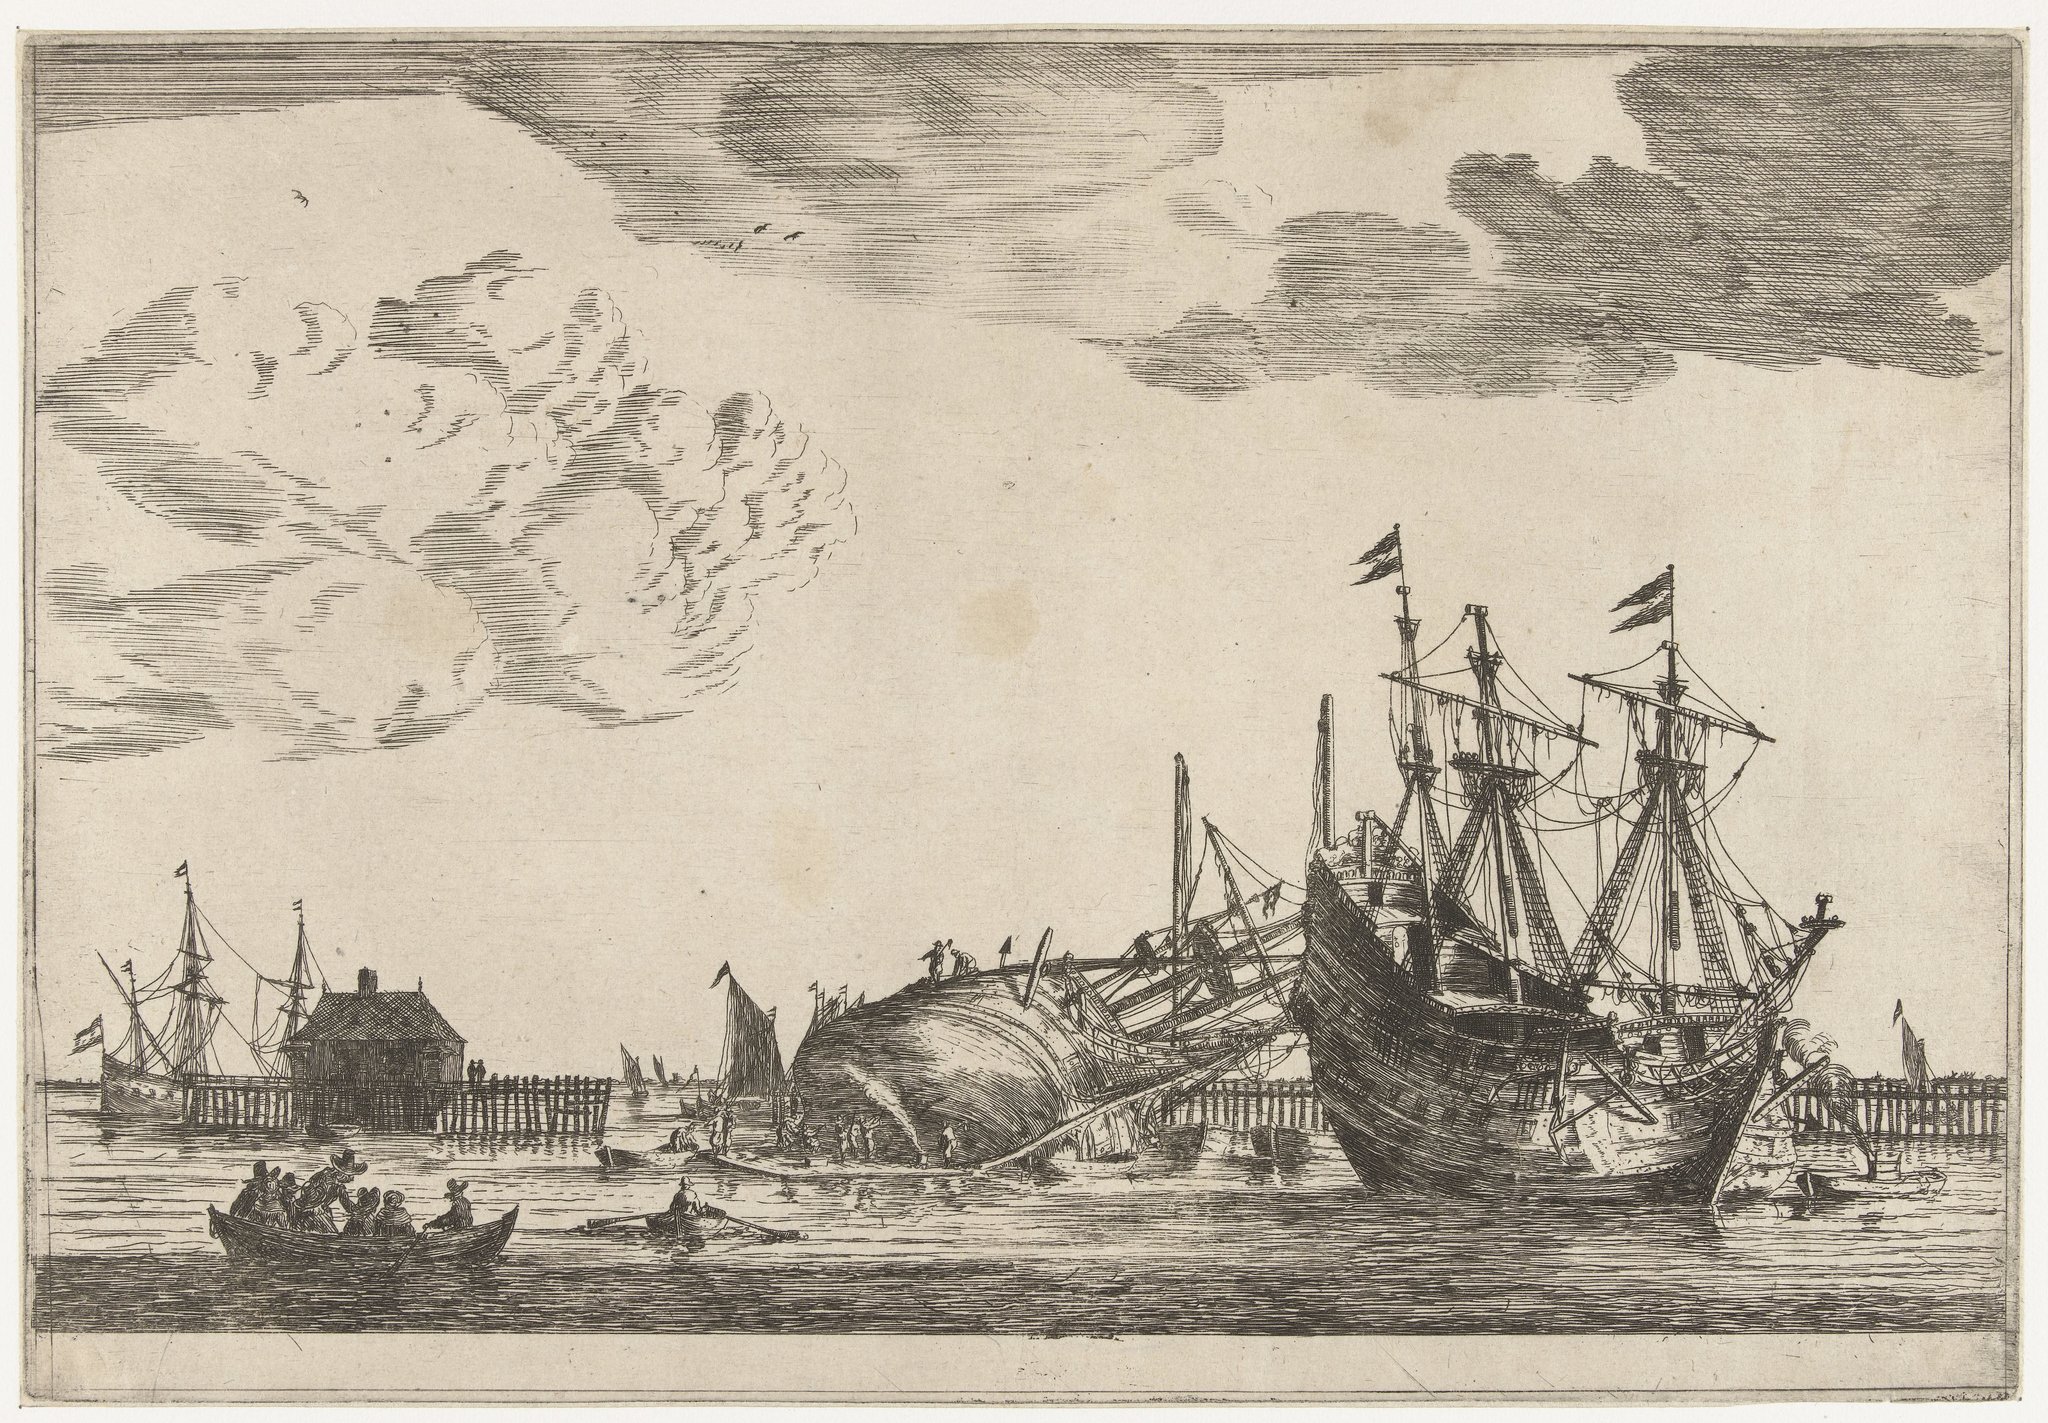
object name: print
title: Dertien scènes met schepen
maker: reinier nooms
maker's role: draughtsman, painter, print maker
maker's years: 1623-1664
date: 1650-1664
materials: paper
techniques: etching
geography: netherlands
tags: sailing-ship, sailing-boat, repairing, caulking, careening (~ ship)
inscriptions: collector's mark: Lugt 2228a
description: Twee zeilschepen achter een golfbreker, het achterste schip is gekield en mannen zijn aan het werk aan de romp om deze waterdicht te maken.